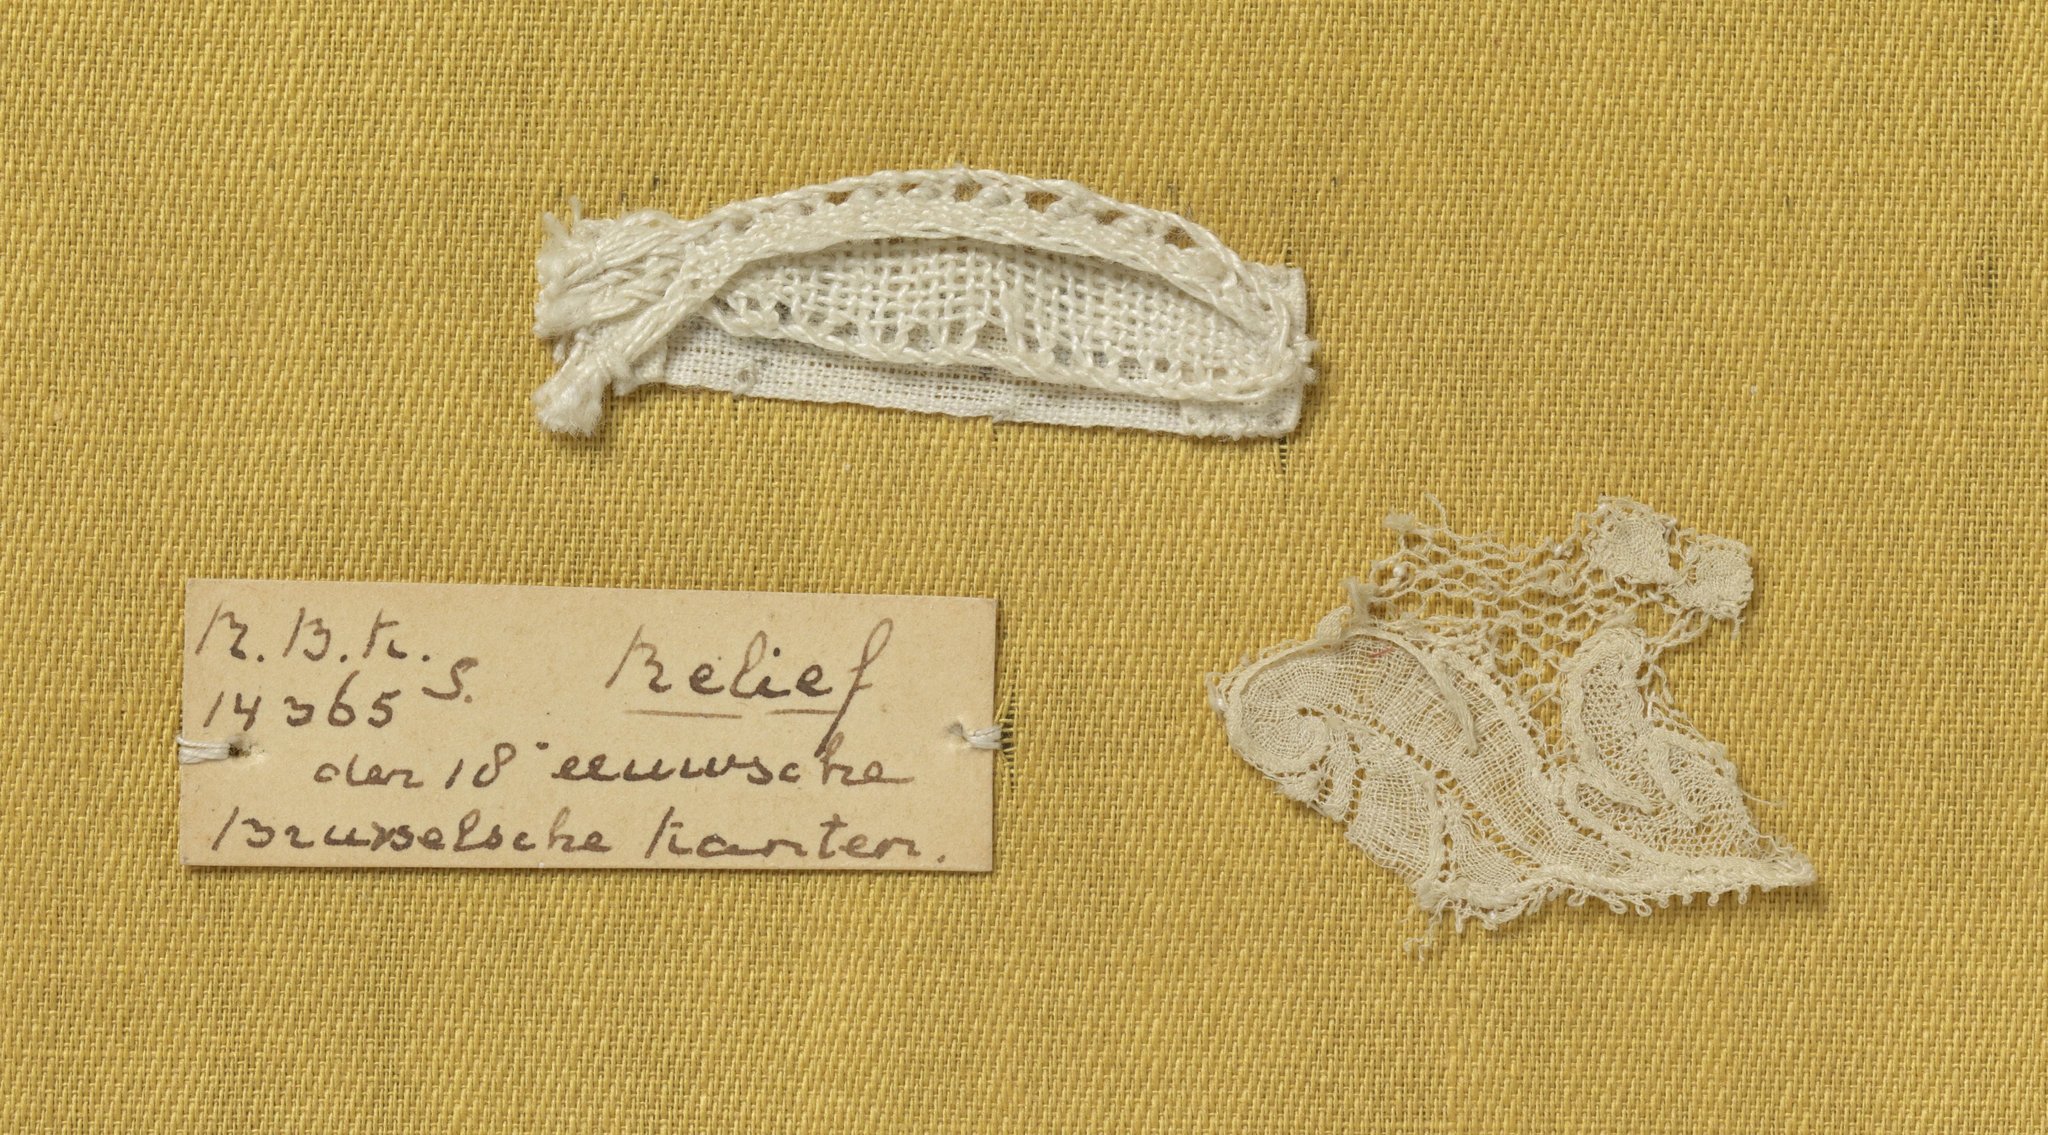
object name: sample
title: Staal kloskant met grove draad als voorbeeld van een 'rib' (18e eeuw)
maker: Anonymous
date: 1900-1930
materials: cotton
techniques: lace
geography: amsterdam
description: Staal naturelkleurige kloskant met grove draad als voorbeeld van een 'rib': een gekloste reliëfcontourlijn. In een bijpassend fragment kant is deze techniek toegepast. Je ziet deze toepassing onder andere in 18e eeuwse Brusselse kloskant. De datering betreft het staal.